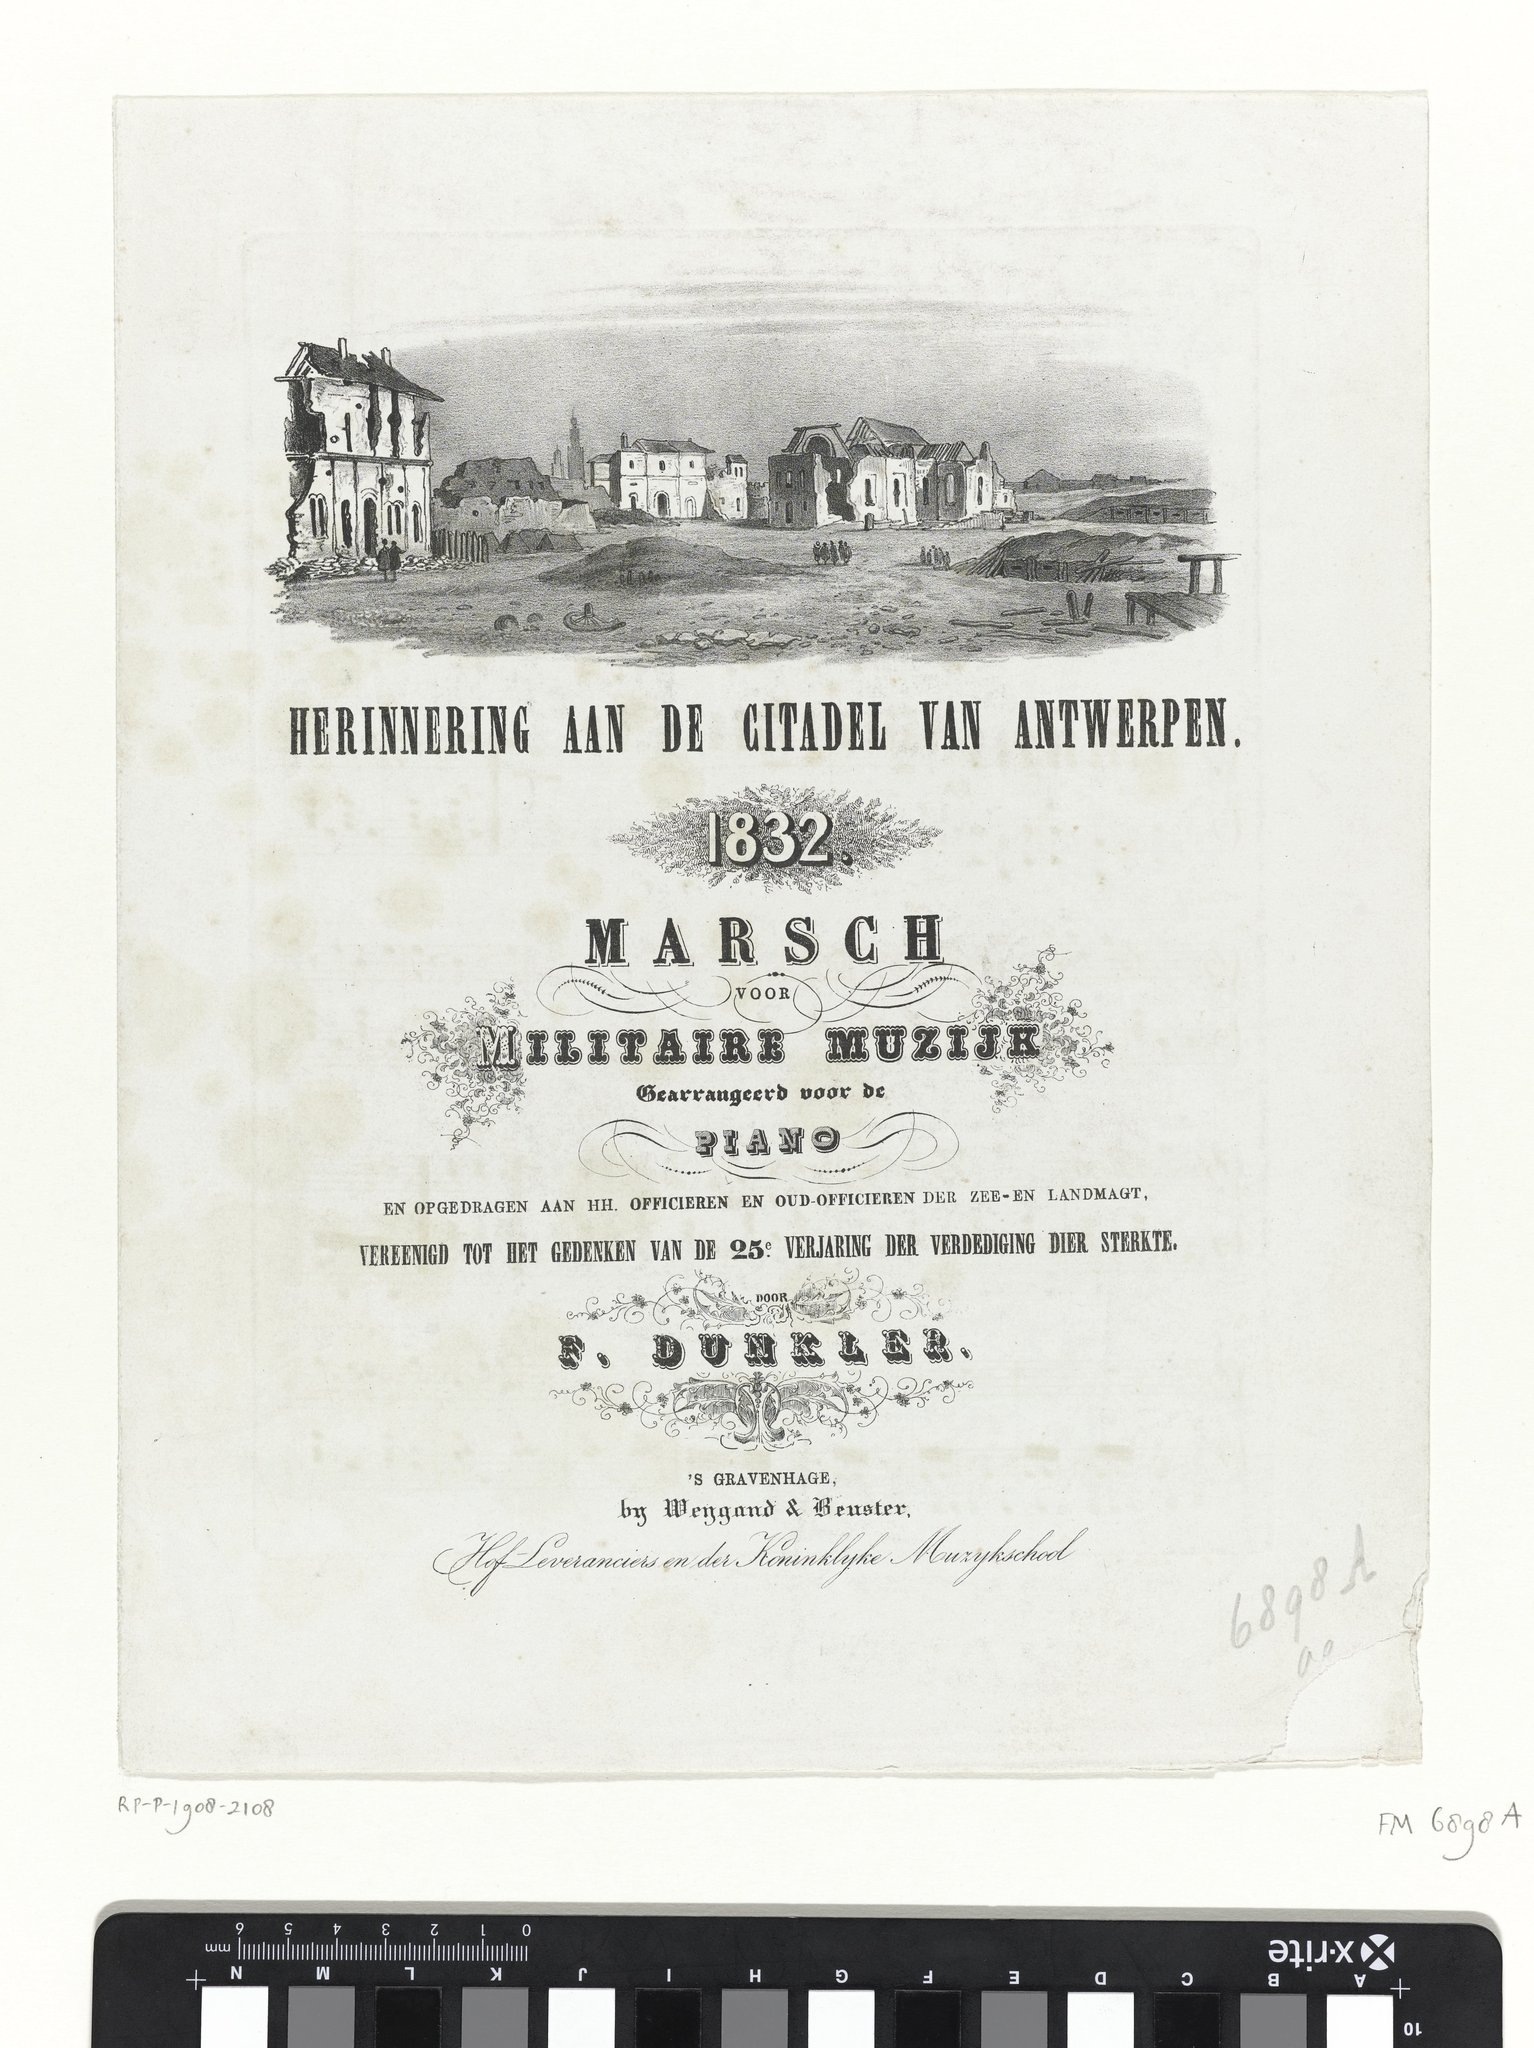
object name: muziekblad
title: Herinnering van de Citadel van Antwerpen. 1832. Marsch voor Militaire Muzijk. Gearrangeerd voor de Piano en opgedragen aan H.H. Officieren en Oud-Officieren der Zee- en Landmagt, vereenigd tot het gedenken van de 25e verjaring dier sterkte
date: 1857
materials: paper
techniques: lithograph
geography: netherlands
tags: printed edition of musical score, devastated, ruined place or city (~ warfare)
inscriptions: collector's mark: Lugt 2228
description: Muziek voor een mars gecomponeerd door F. Dunkler en getiteld 'Herinnering van de Citadel van Antwerpen. 1832', ter gelegenheid van het 25-jarig jubileum in 1857 van de verdediging van de vesting in december 1832. Dubbelgevouwen blad met op de voorzijde een gezicht op de ruïnes van de citadel na de overgave. Binnenin de bladmuziek.